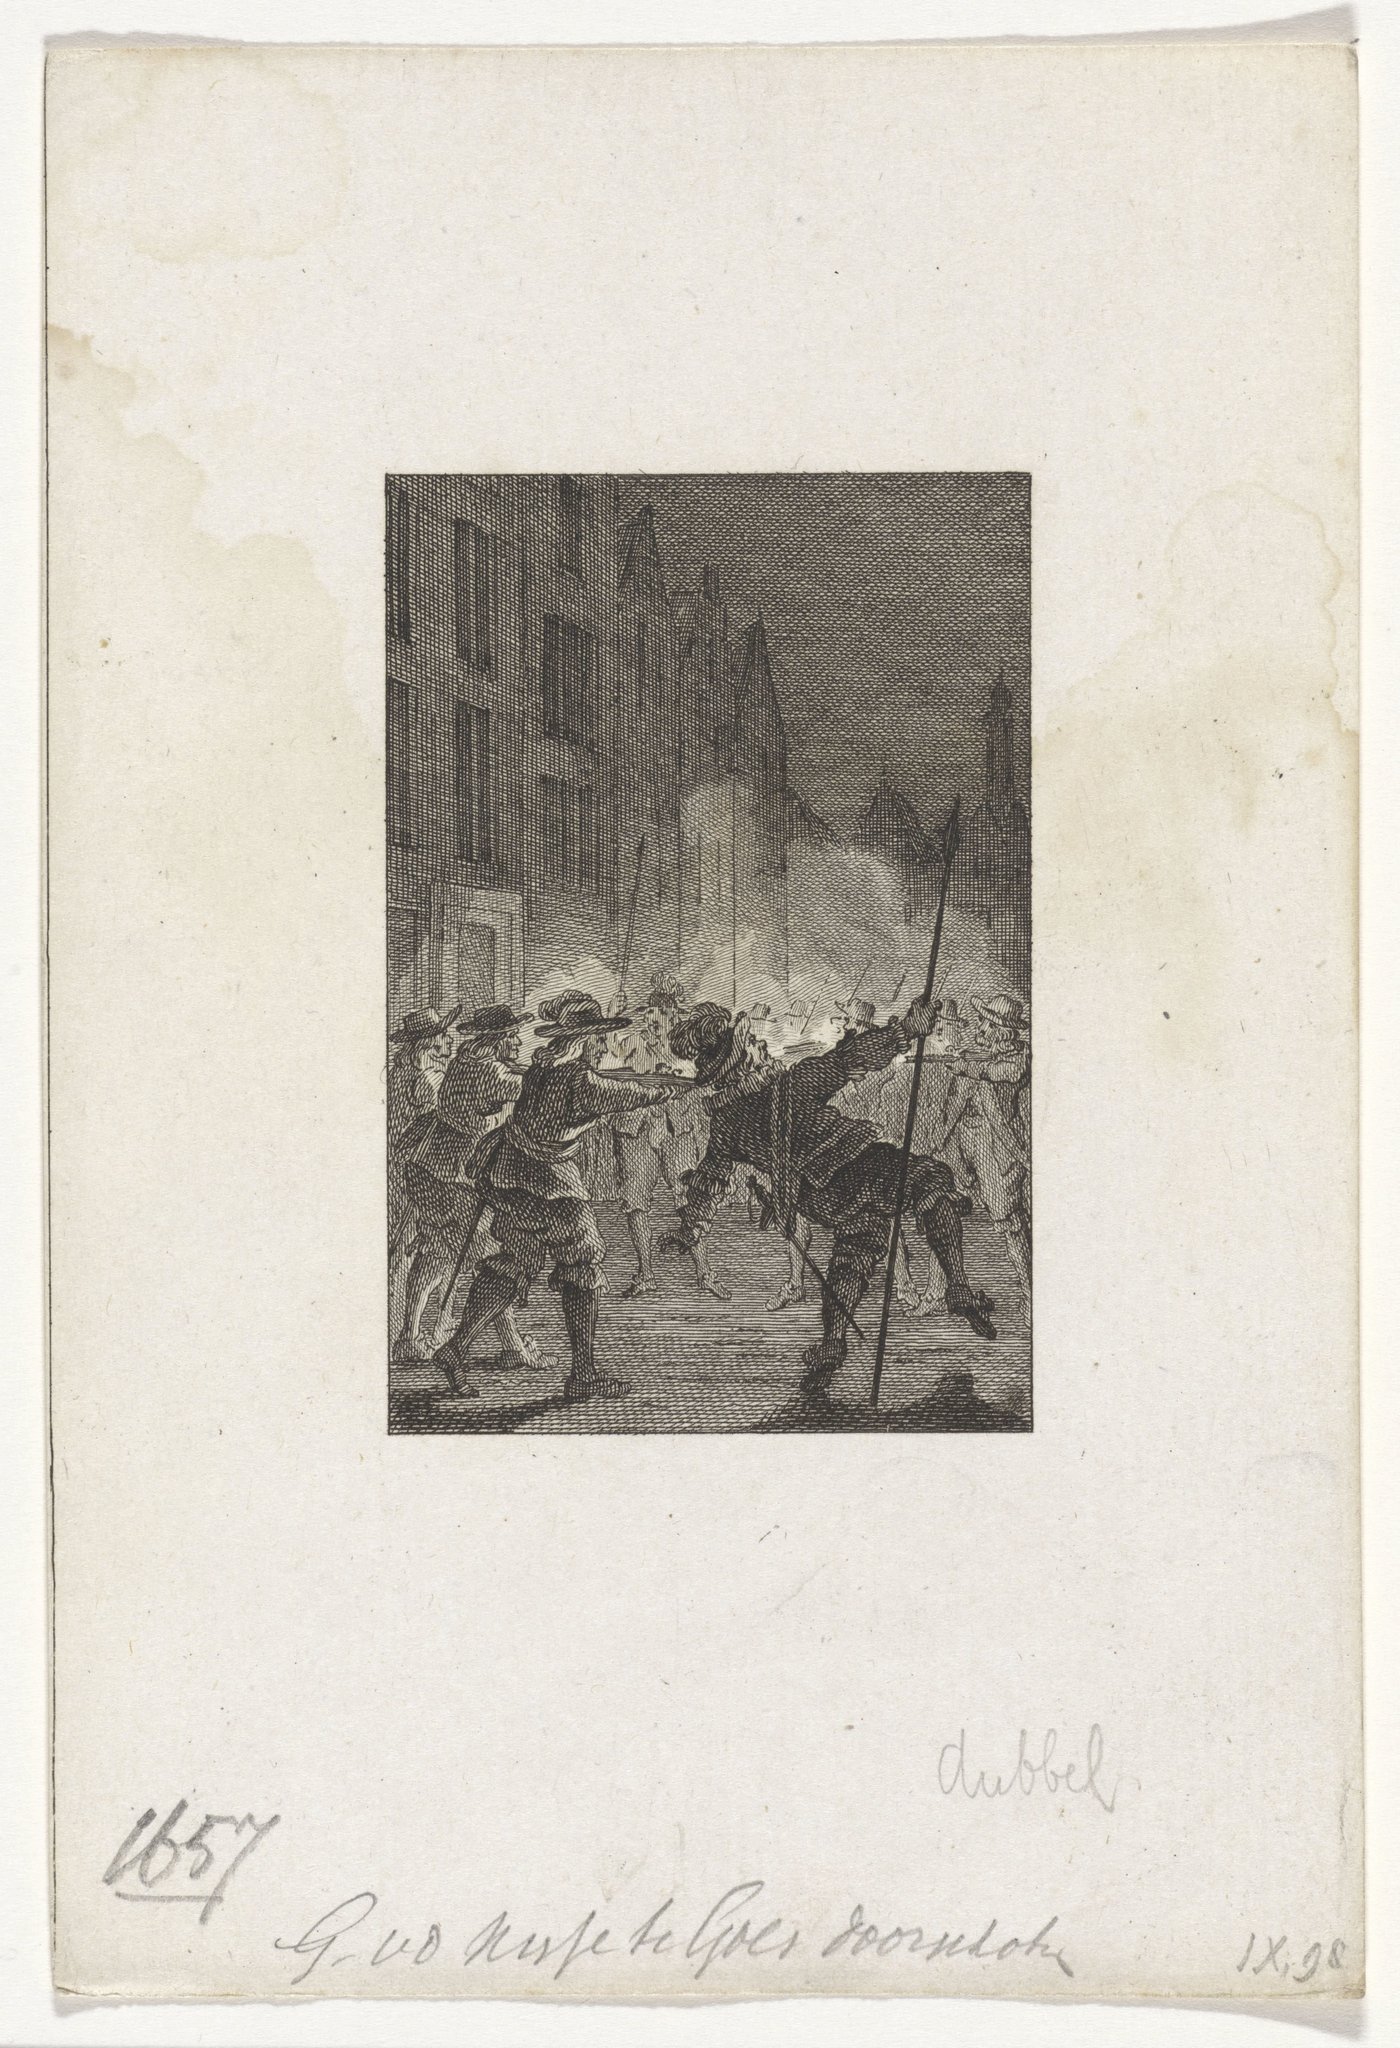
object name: history print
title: Gillis van der Misse gedood te Goes, 1657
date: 1783-1795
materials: paper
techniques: etching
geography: amsterdam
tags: violent death, being killed; being mishandled and maltreated; seeking death, street-fights, riots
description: Gillis van der Misse gedood te Goes bij een poging het oproer op straat over de verkiezing van rentmeesters te stillen, maart 1657. Van der Misse wordt geraakt tijdens een vuurgevecht op straat.